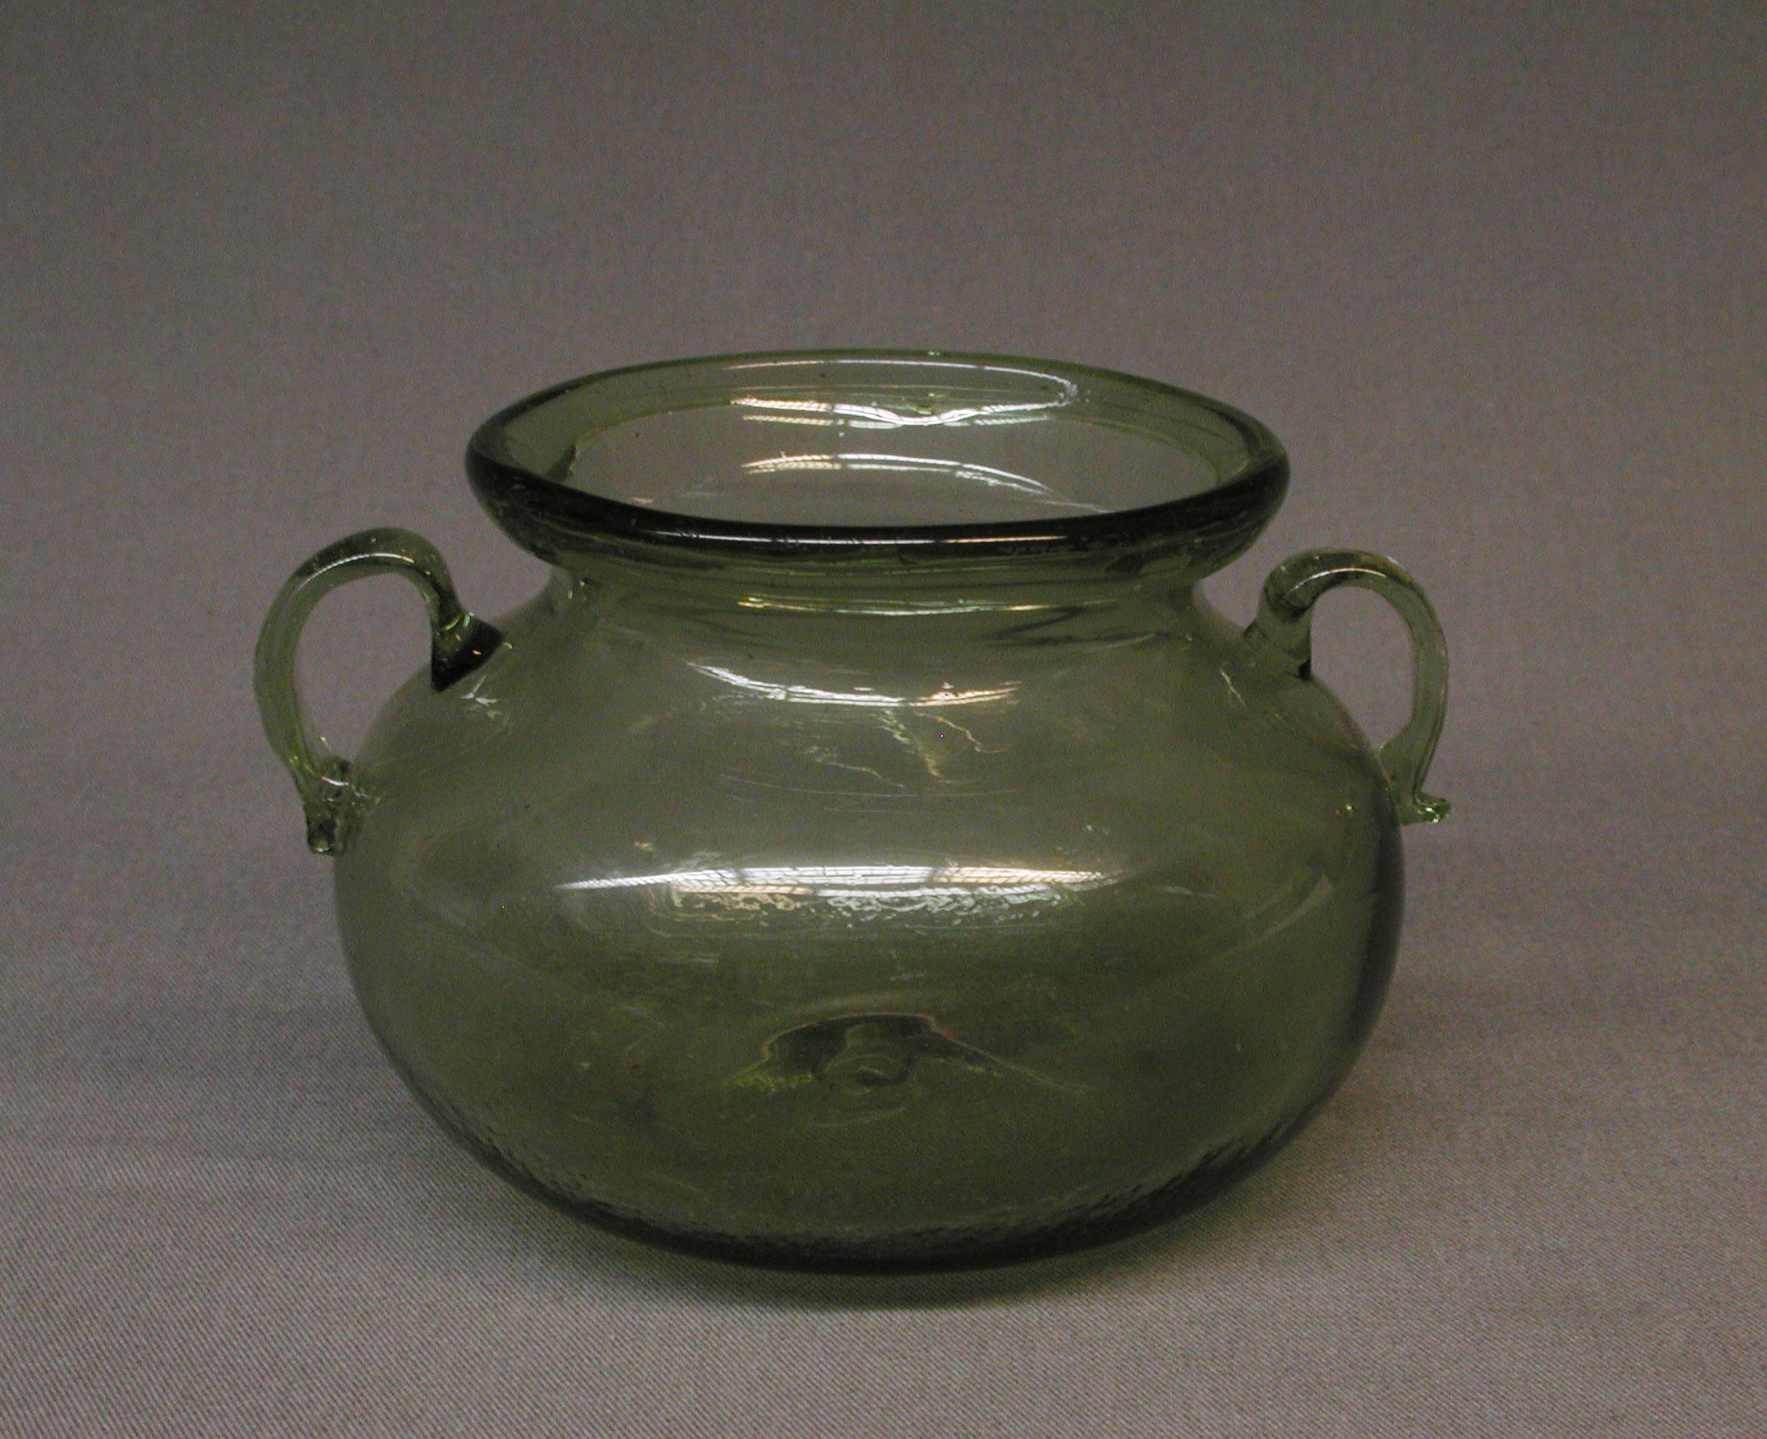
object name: bowl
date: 1601-1800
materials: glass